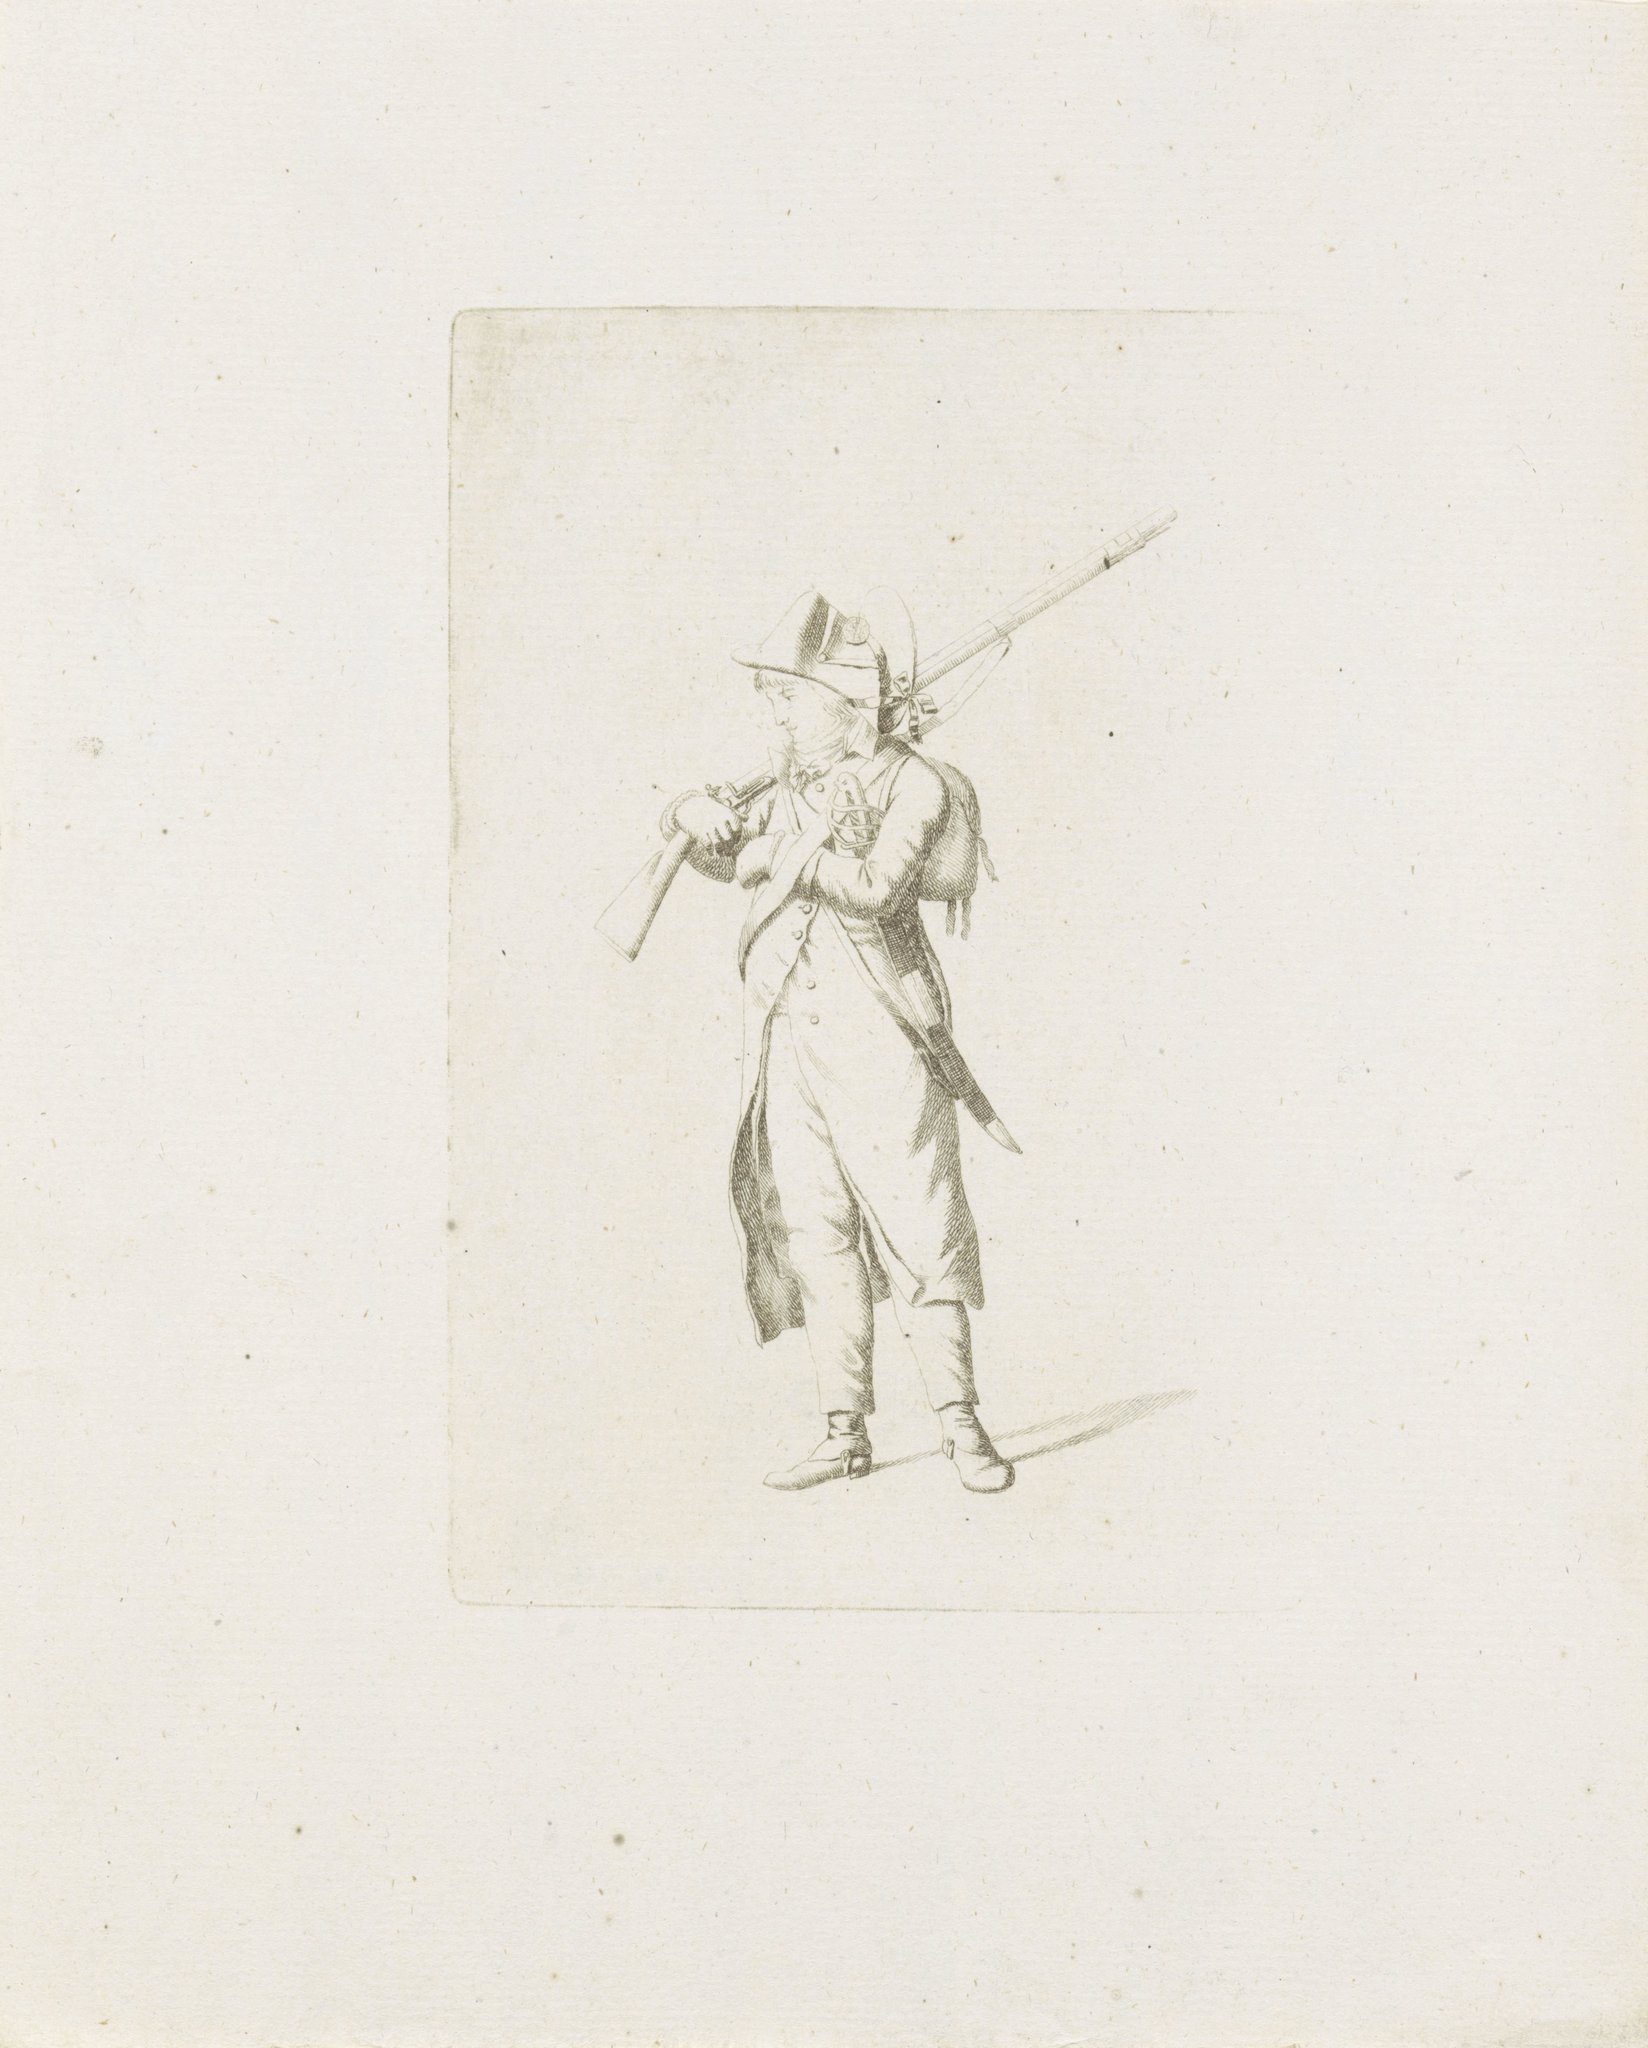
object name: print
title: Franse infantrie in Nederland in 1795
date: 1795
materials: paper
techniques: engraving, etching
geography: northern netherlands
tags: (military) uniforms (+ infantry), clothes, costume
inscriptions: collector's mark: Lugt 2228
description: Een staande Franse soldaat, naar links. Onderdeel van een serie van vijftien platen van Franse infanterie, vooral soldaten en enkele officieren, in ongeregelde uniform of kleding, zoals deze in 1795 in de Republiek aankwam.